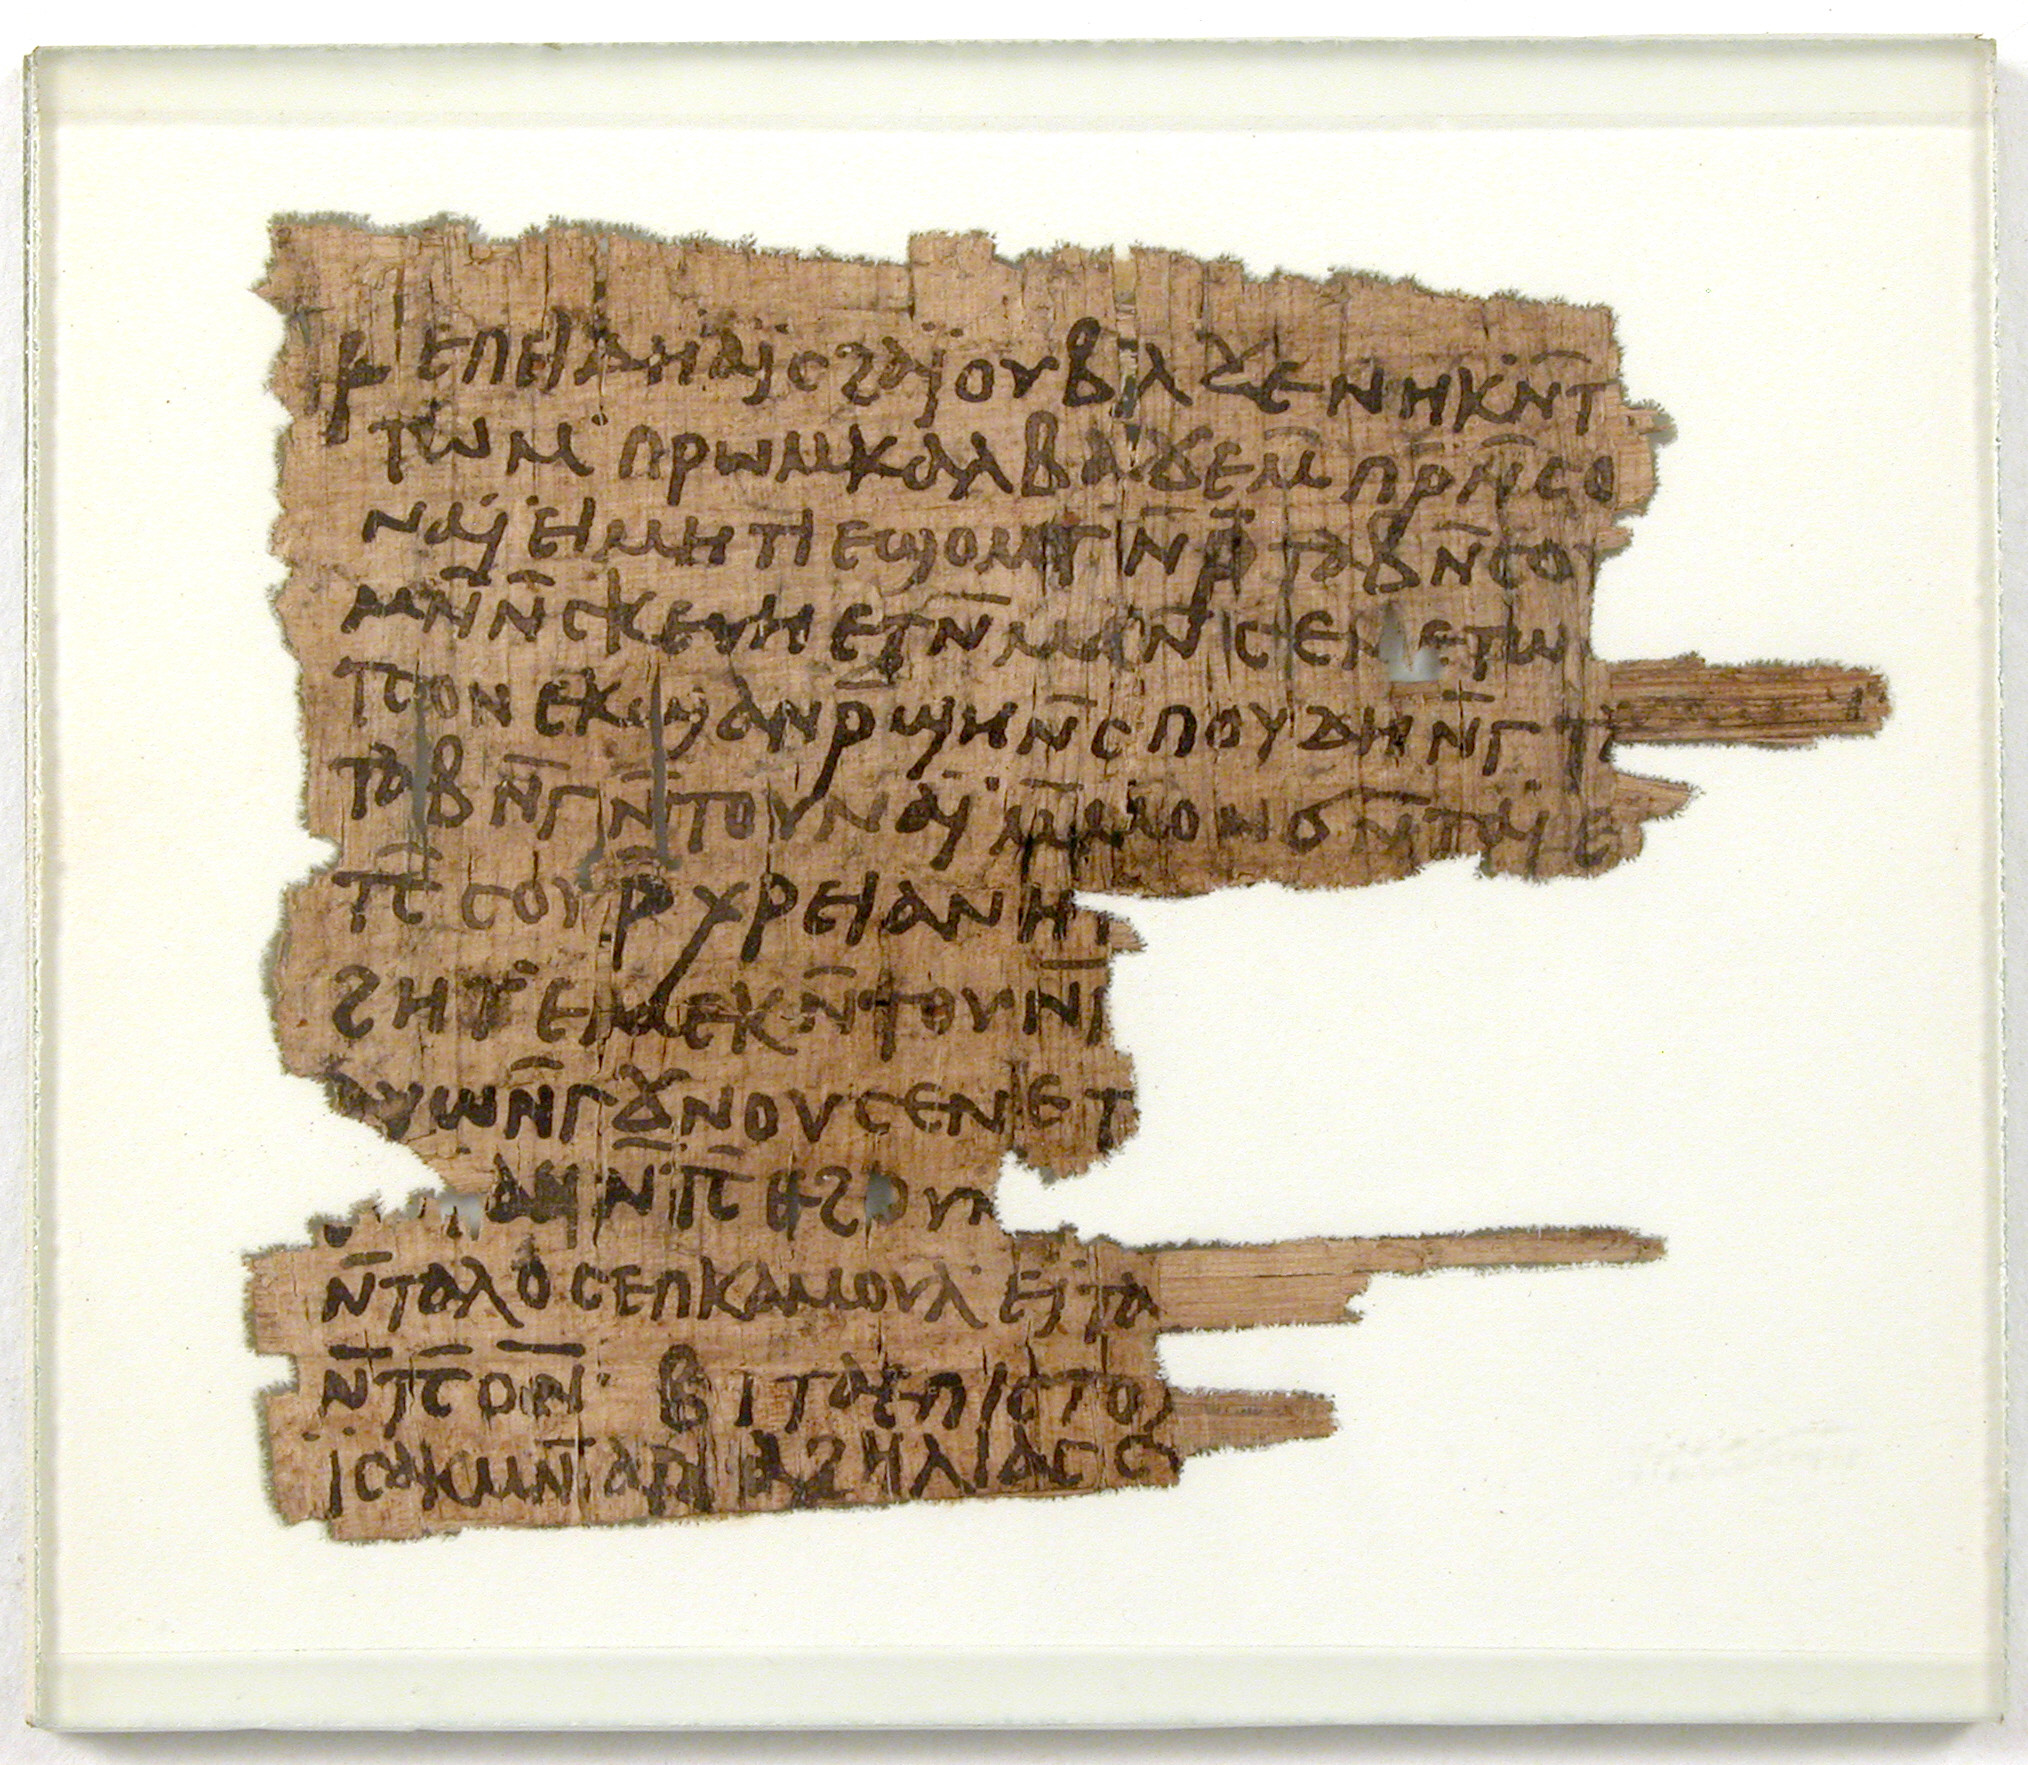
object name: fragment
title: Papyri Fragments of a Letter to Andreas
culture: coptic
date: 601-700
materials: ink, papyrus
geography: egypt